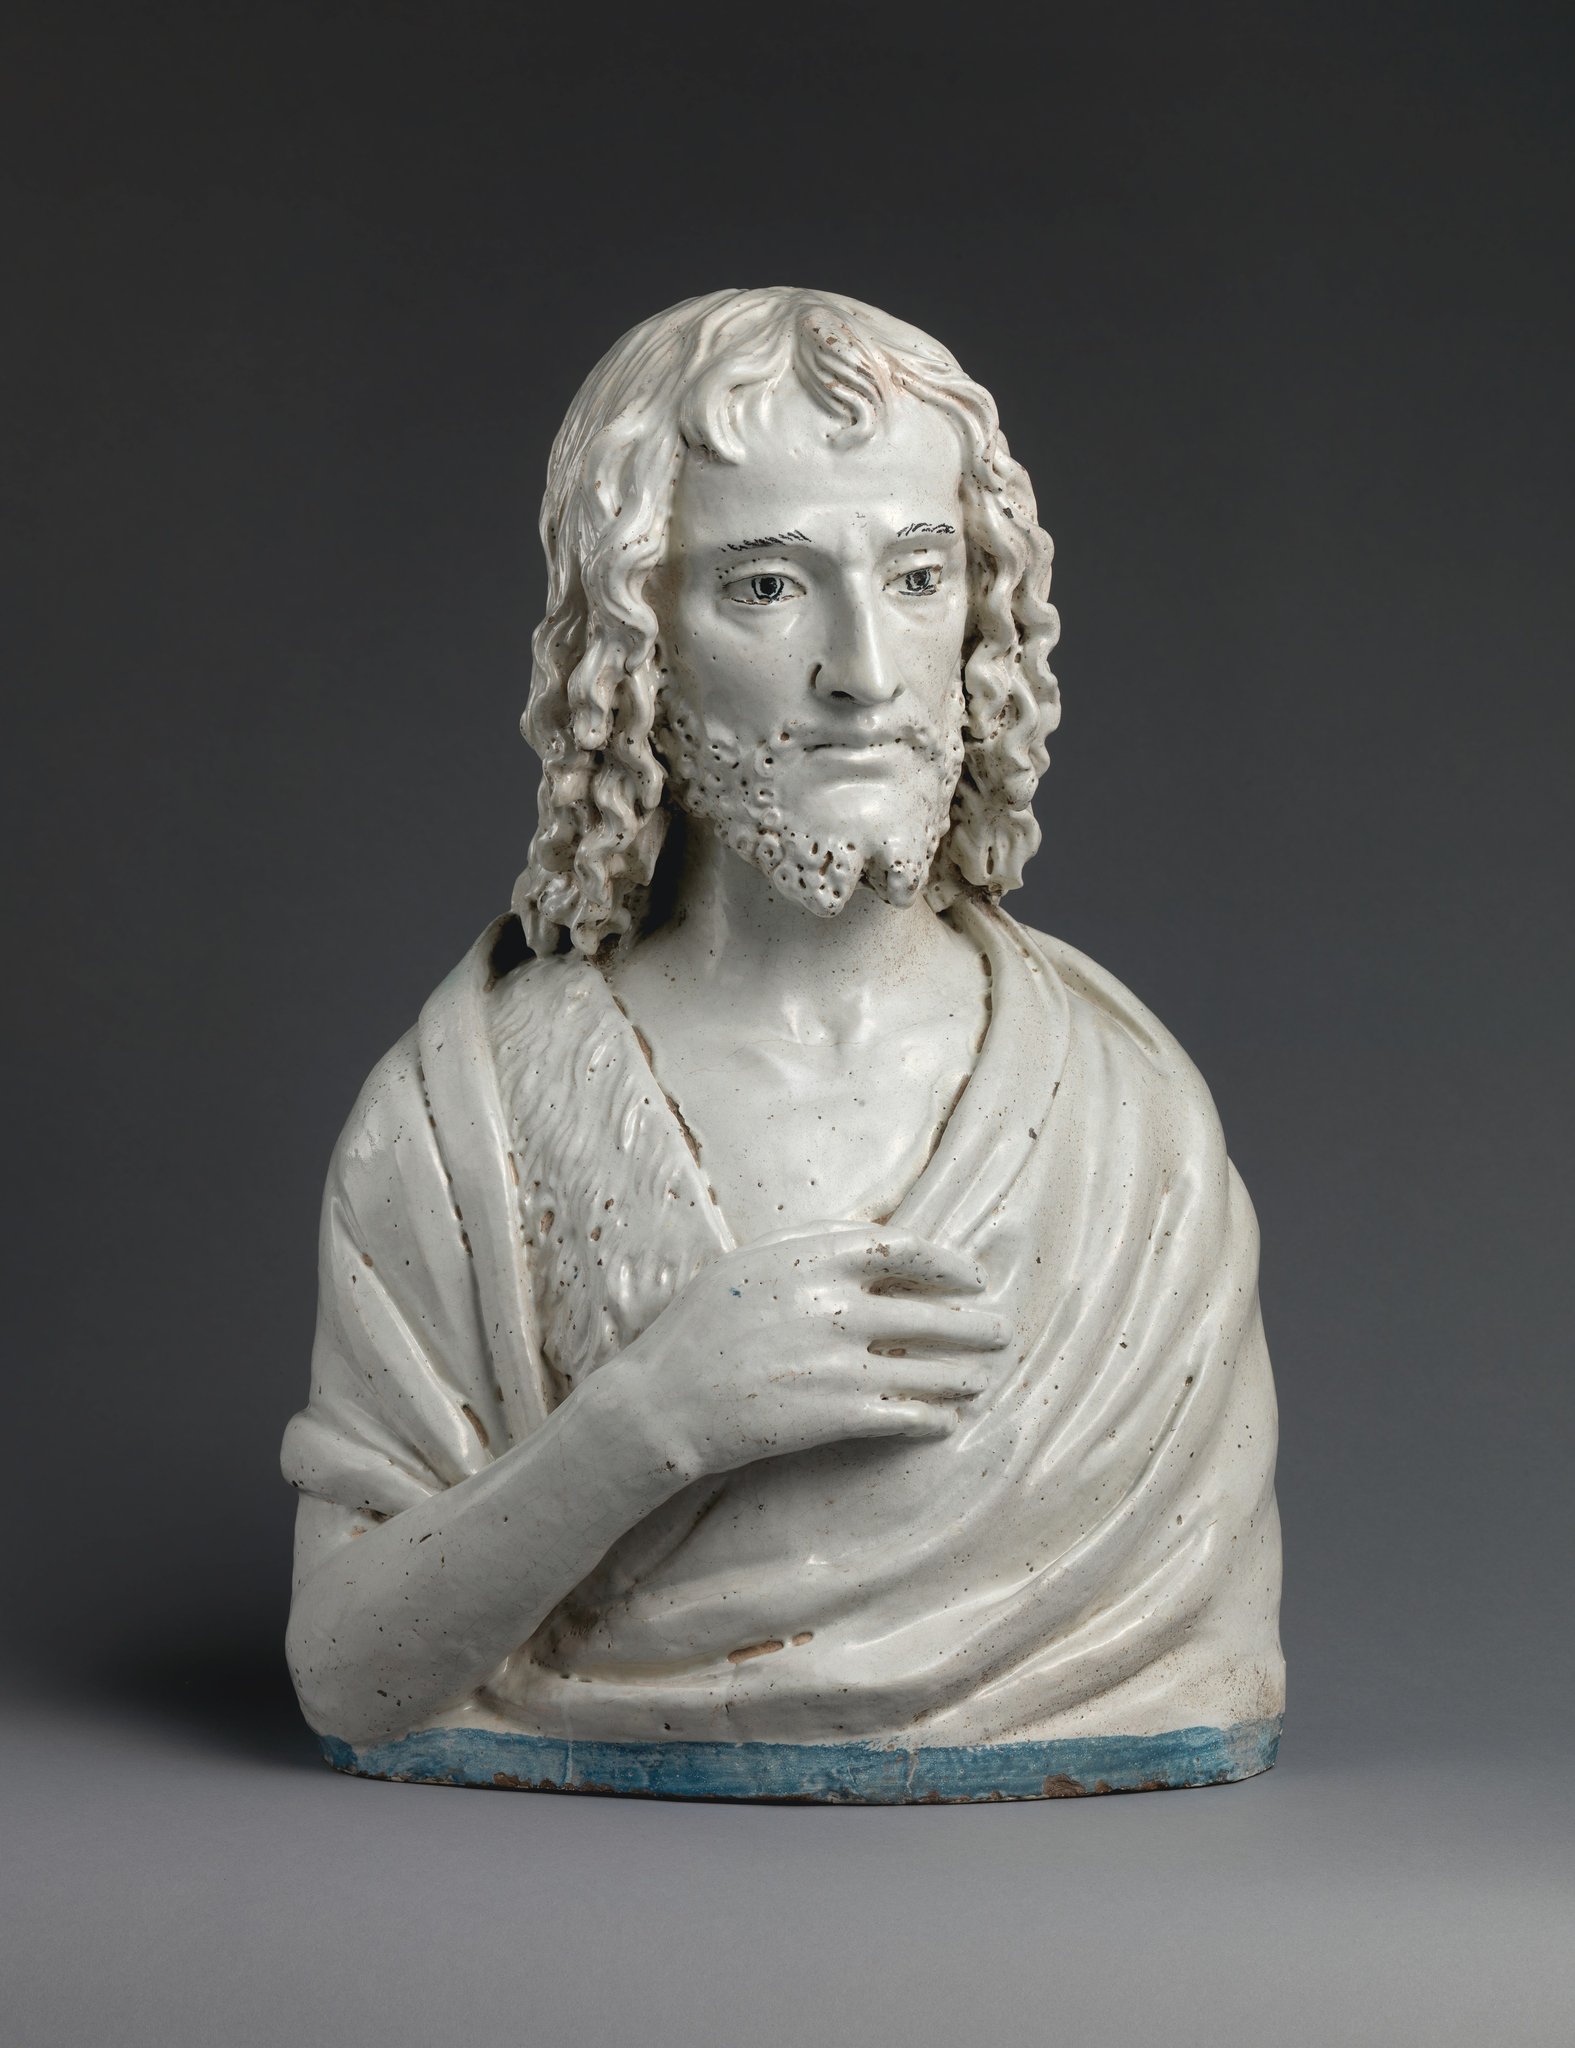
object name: bust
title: St. John the Baptist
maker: benedetto buglioni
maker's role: artist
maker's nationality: italian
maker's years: 1459-1521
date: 1501-1600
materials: terracotta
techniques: glazing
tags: saint john the baptist